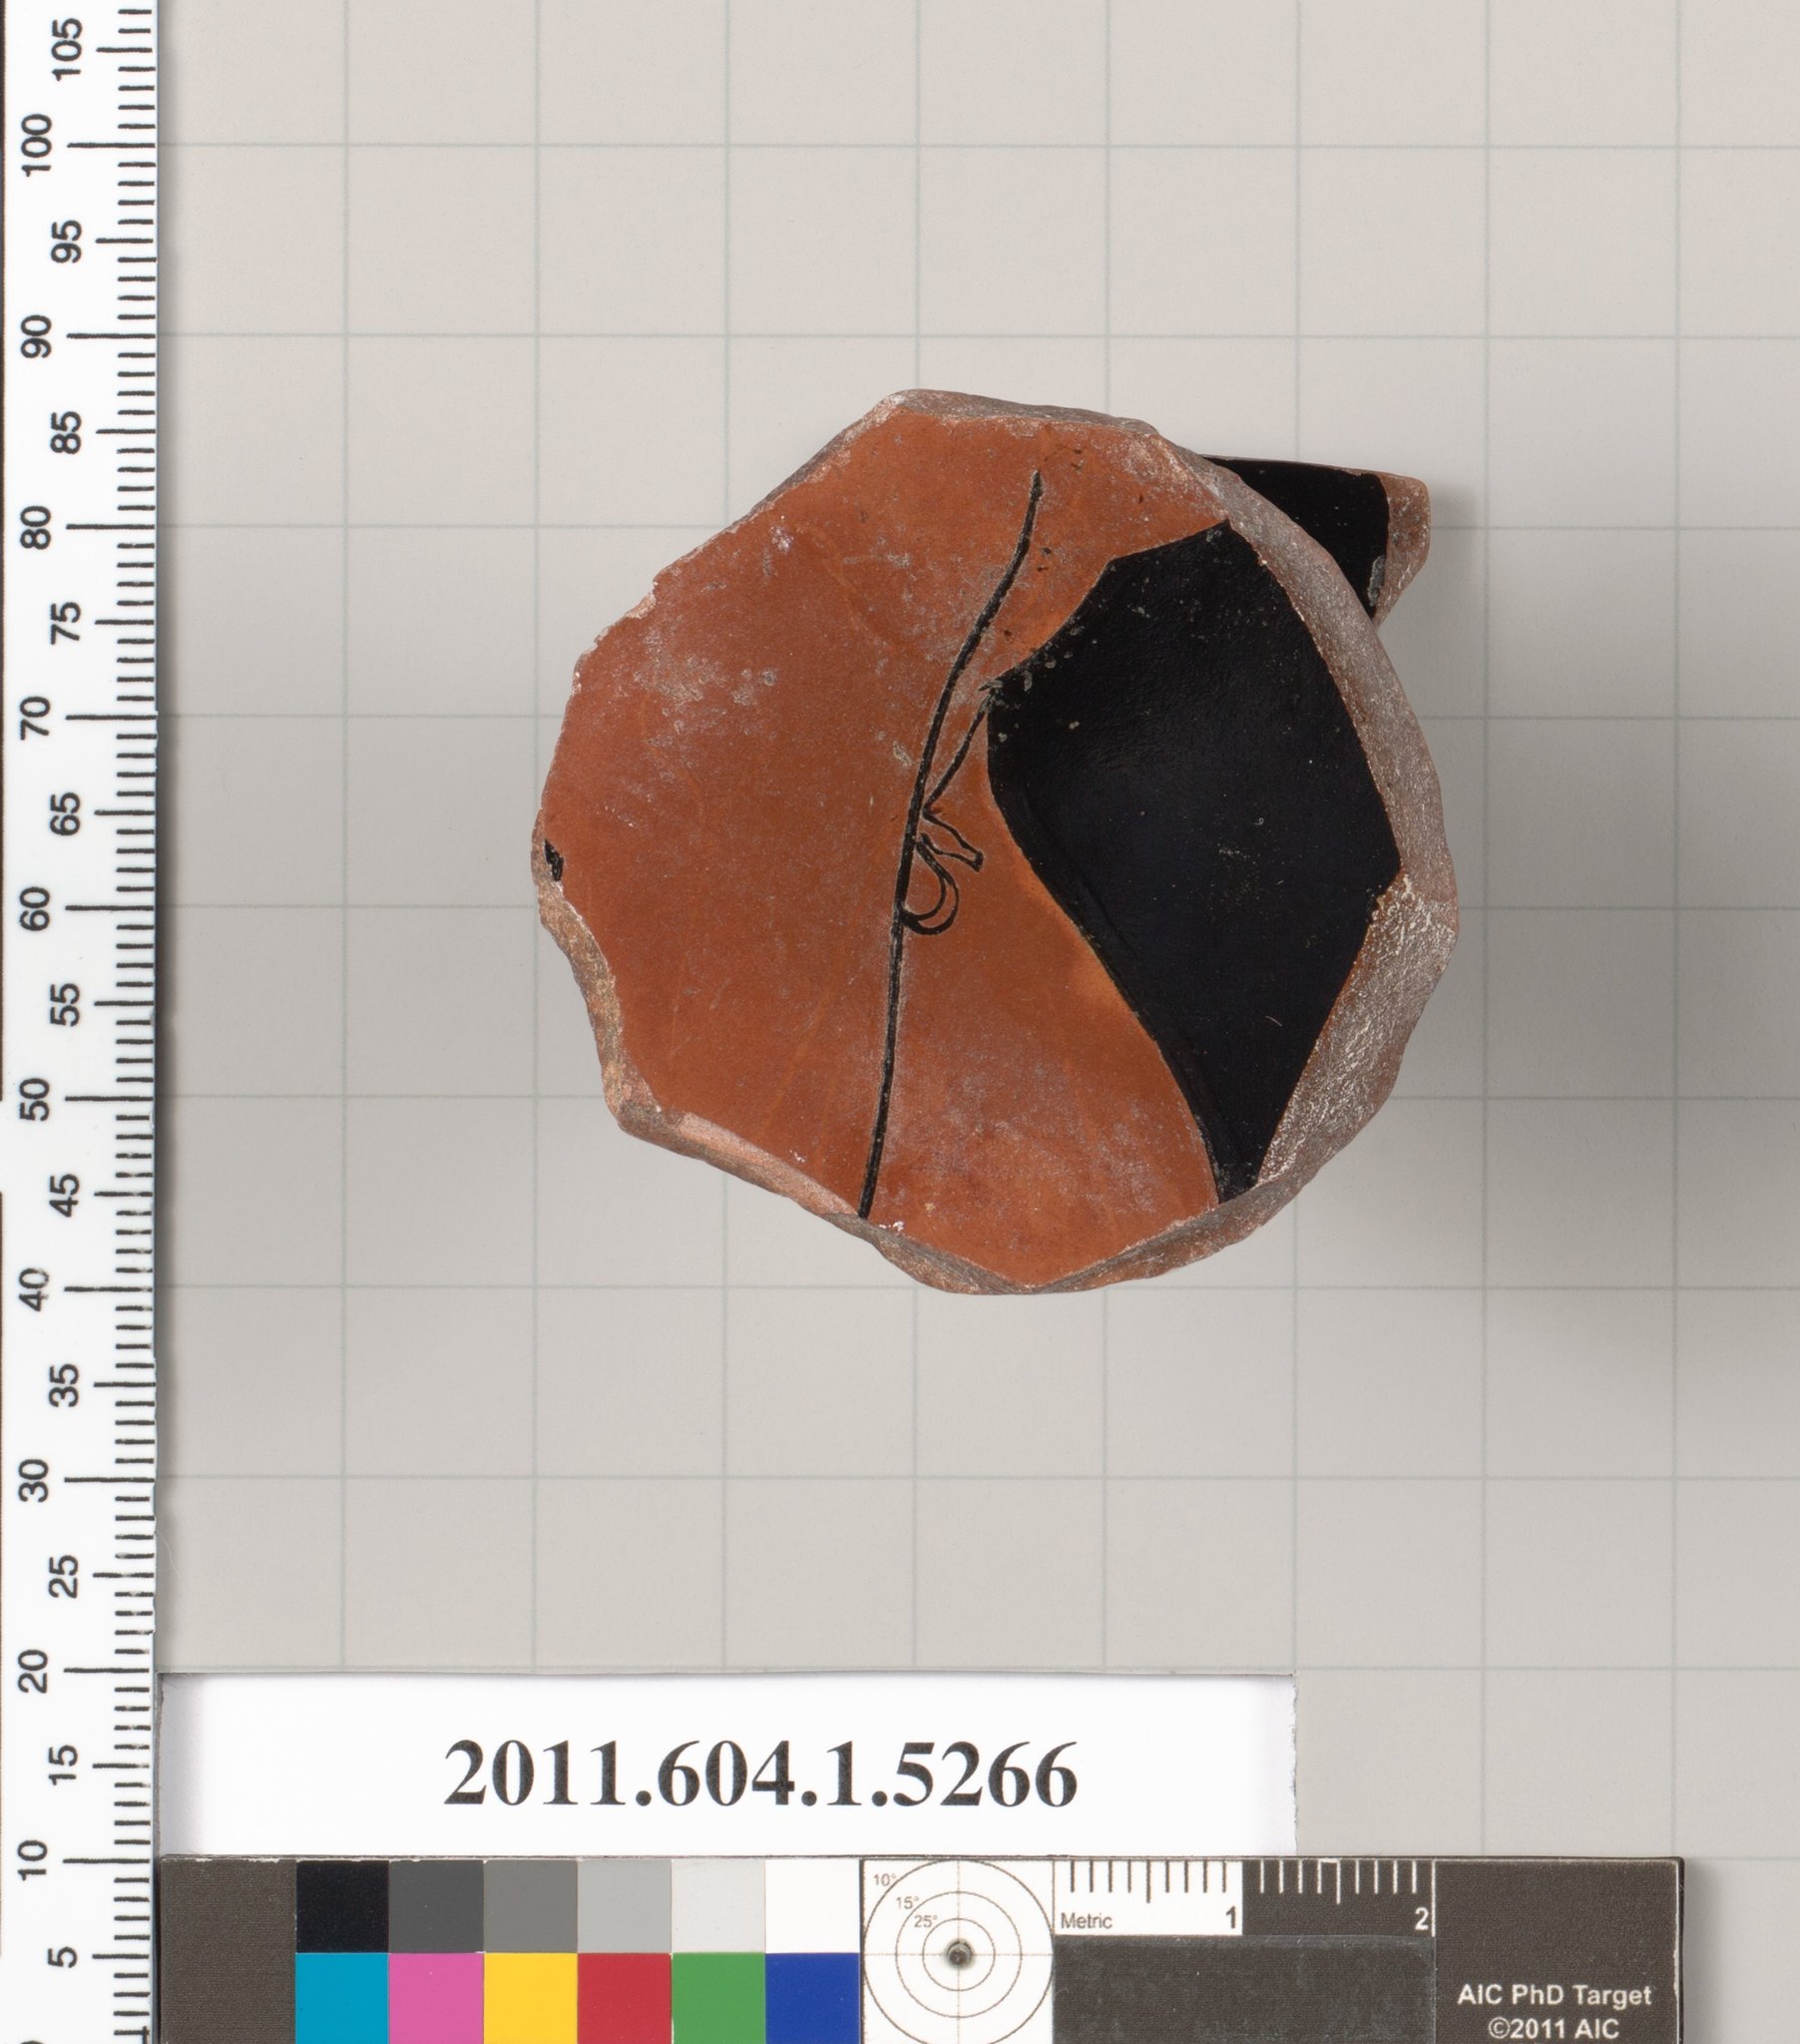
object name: kylix fragment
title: Terracotta fragment of a kylix (drinking cup)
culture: greek, attic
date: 500-480 BCE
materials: terracotta